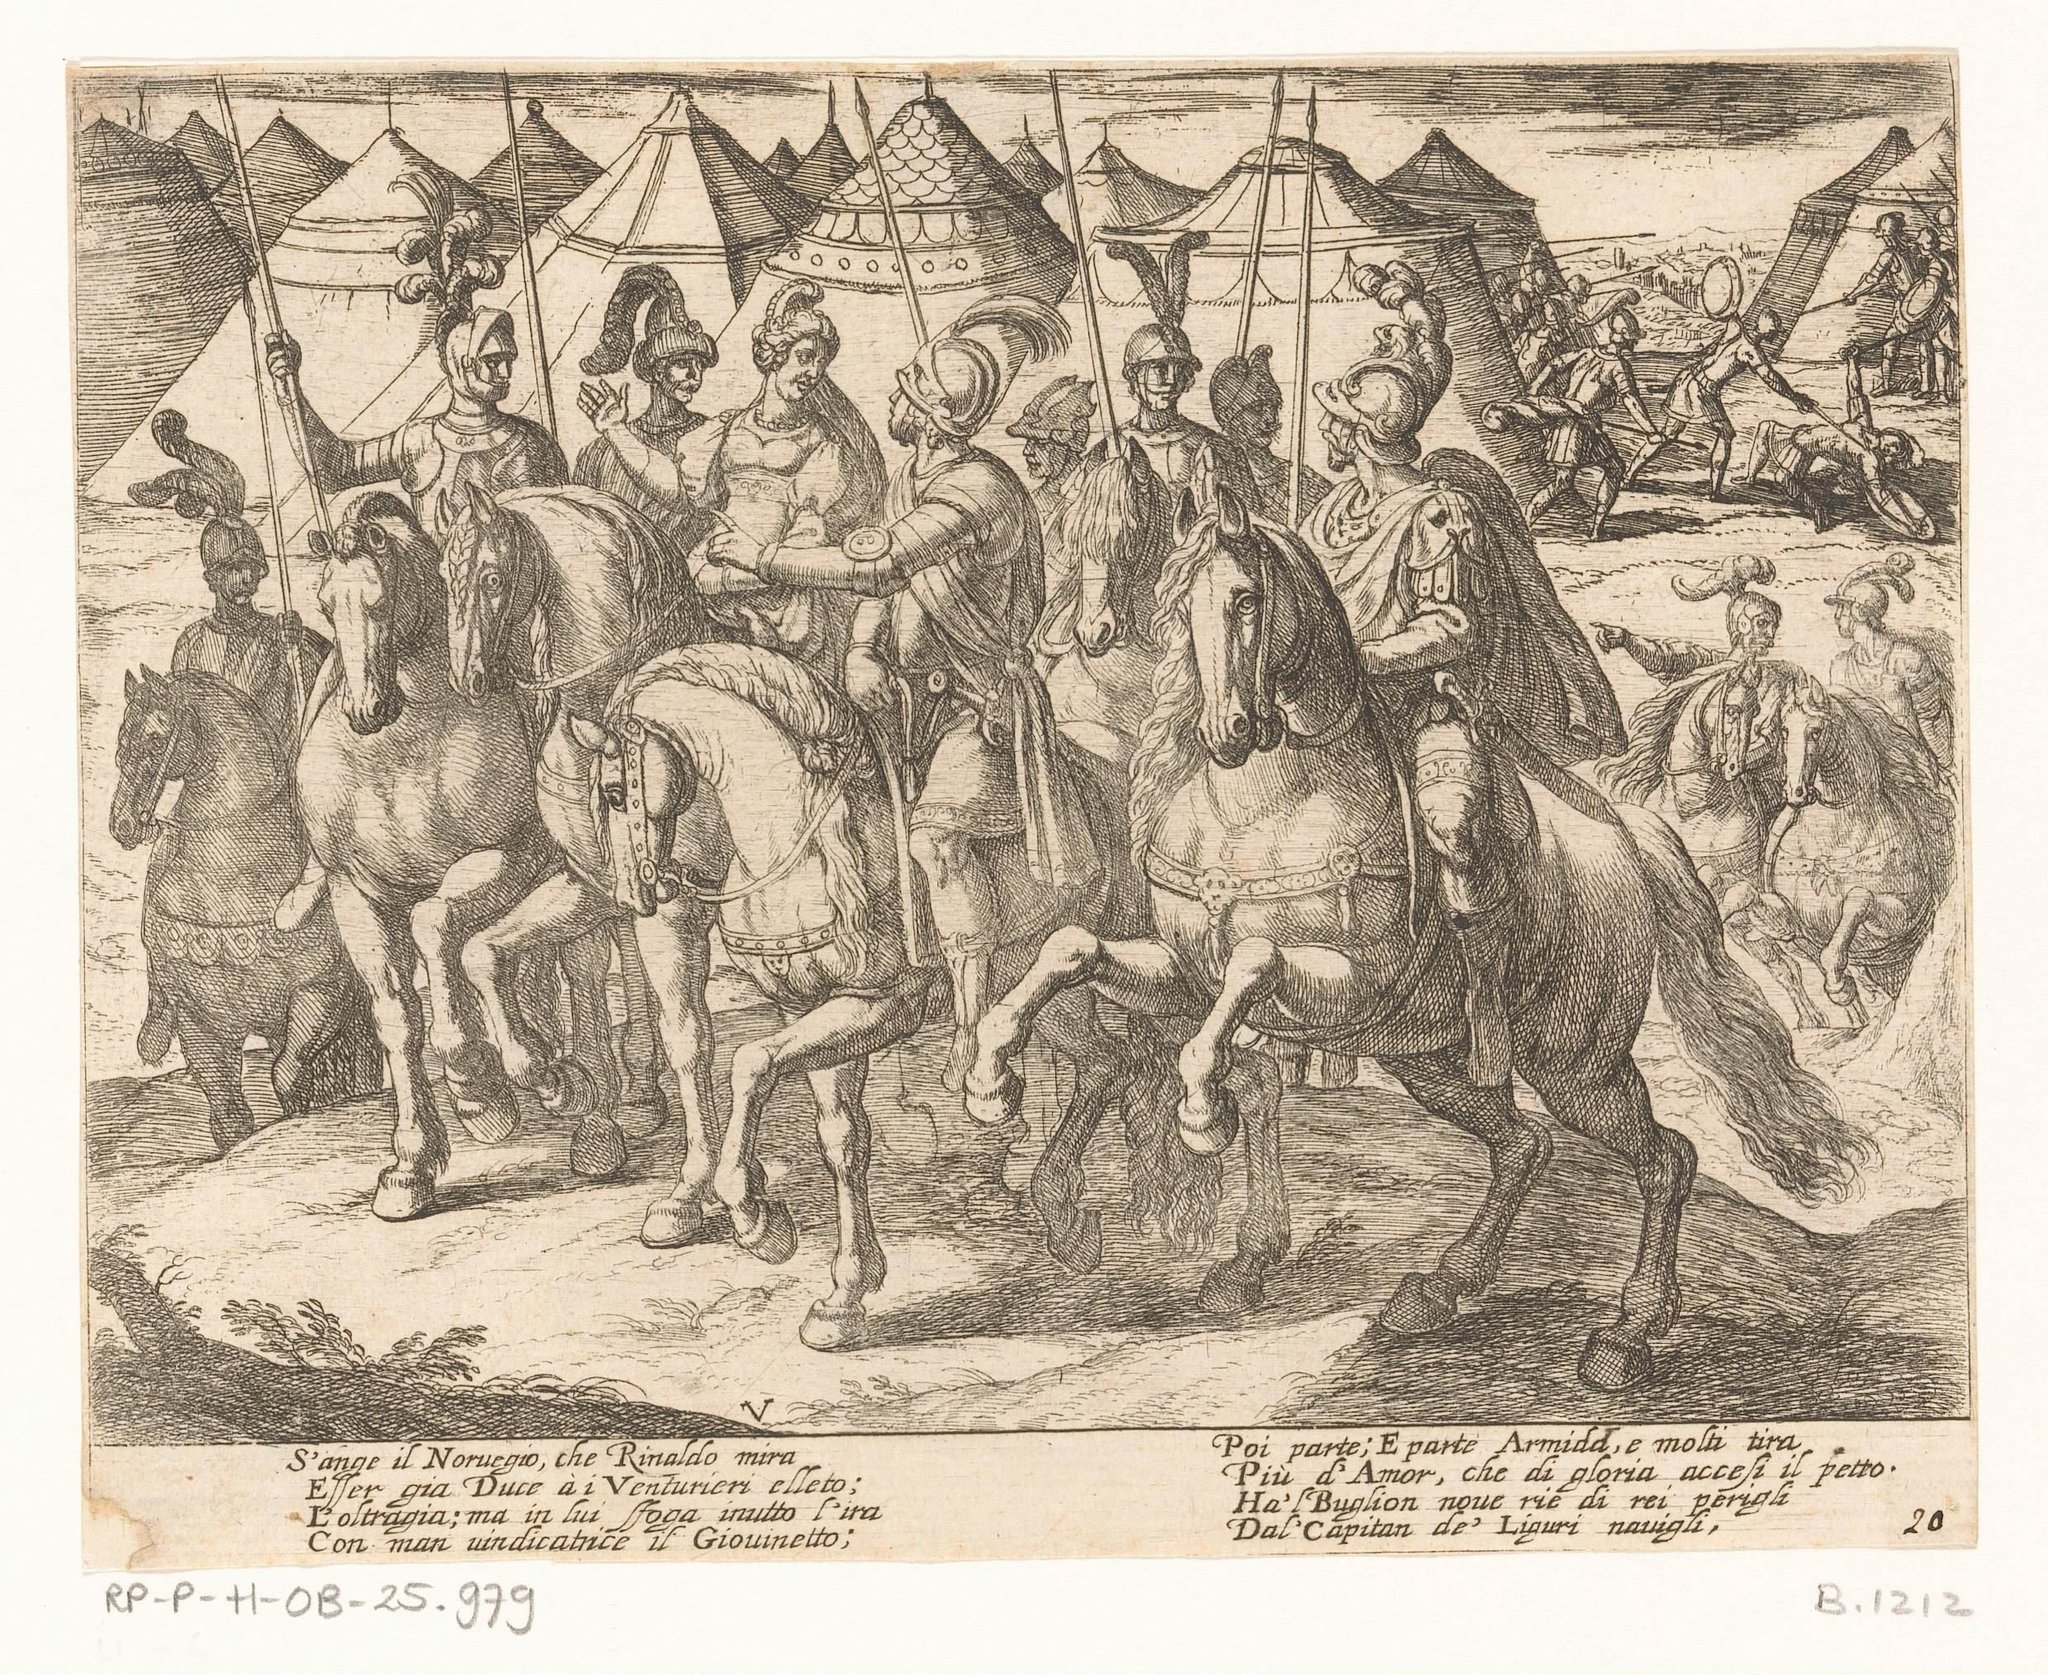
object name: print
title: Gerusalemme Liberata (deel 2)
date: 1565-1630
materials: paper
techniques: etching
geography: italy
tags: warfare; military affairs (+ cavalry, horsemen), militant proselytizing: religious war, crusade, etc., (scenes from) specific works of literature: tasso, gerusalemme liberata, knight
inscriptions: collector's mark: Lugt 11, collector's mark: ‘Hinloopen’, number: ‘20’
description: Deze prent maakt deel uit van een reeks van twintig prenten (+ opdracht) met voorstellingen van scènes uit Tasso's 'Jeruzalem verlost', een episch gedicht geschreven door de Italiaanse dichter Torquato Tasso en voor het eerst gepubliceerd in 1581. Het verhaal vertelt grotendeels in fictie over de Eerste Kruistocht waarin de christenen, geleid door Godfried van Bouillon, de strijd aangaan met de moslims om het Beleg van Jeruzalem.